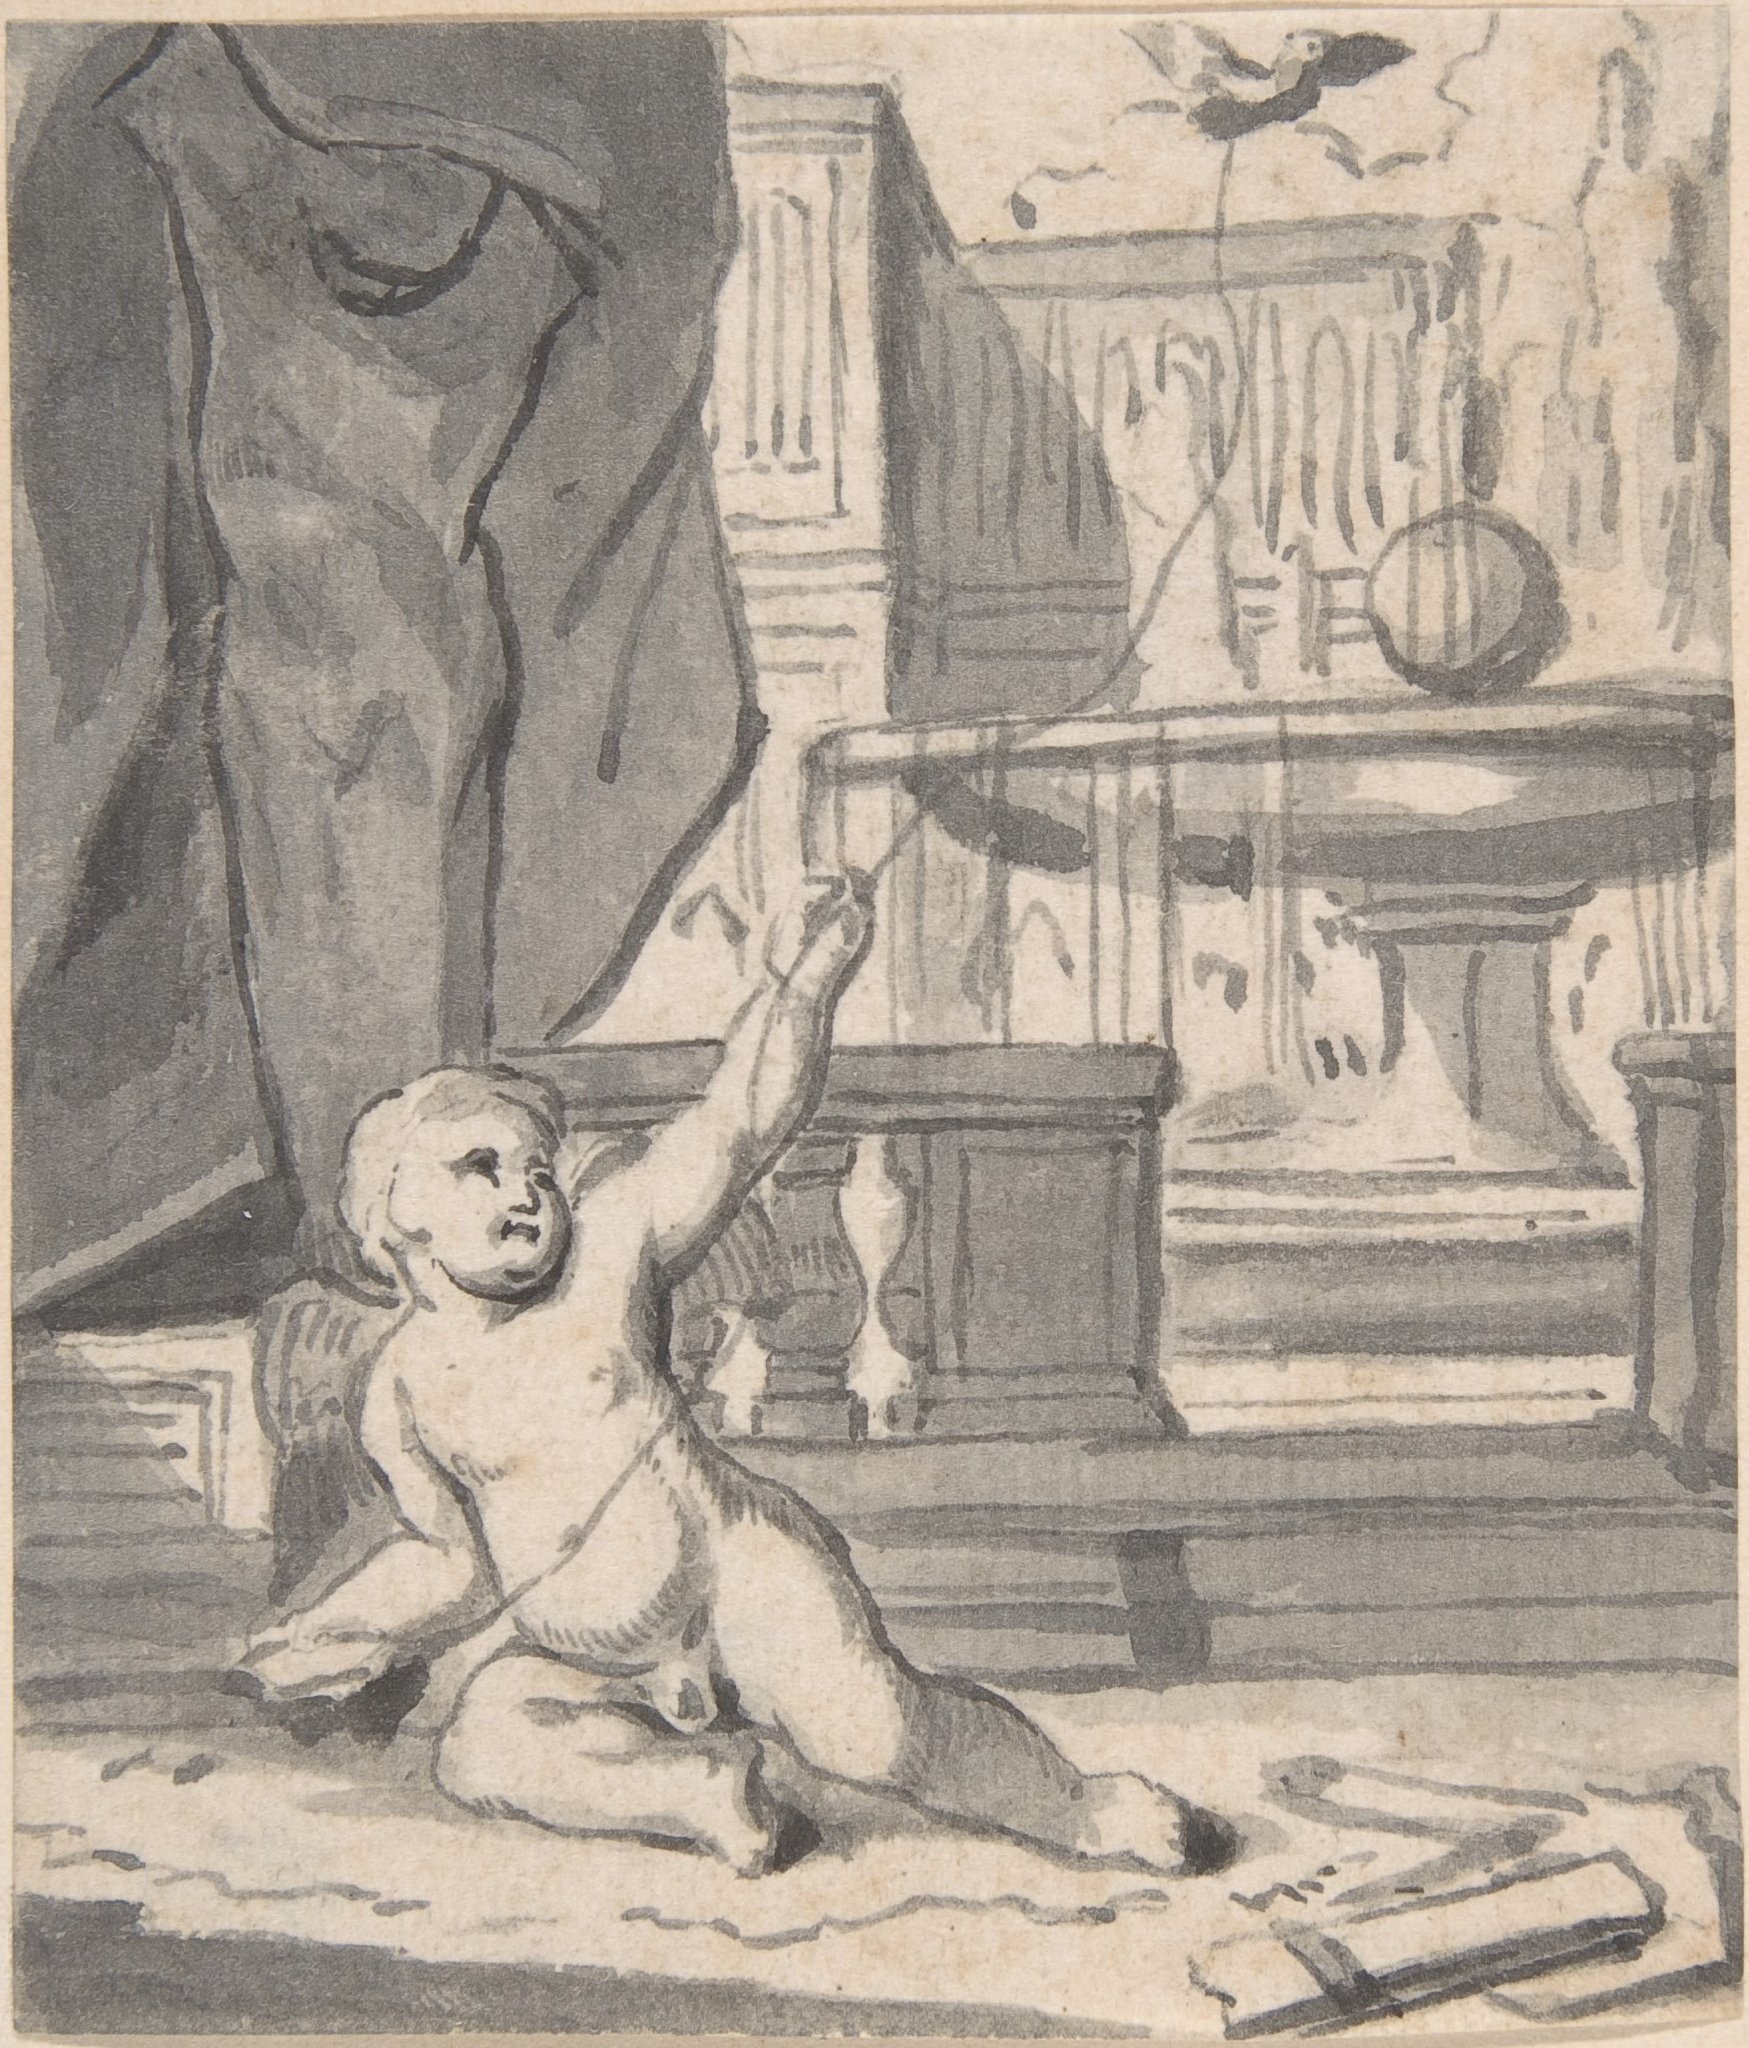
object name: drawing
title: Cupid with a Bird on a String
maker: joseph werner the younger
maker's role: artist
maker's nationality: swiss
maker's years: 1637-1710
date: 1601-1733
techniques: brush, wash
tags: birds,cupid